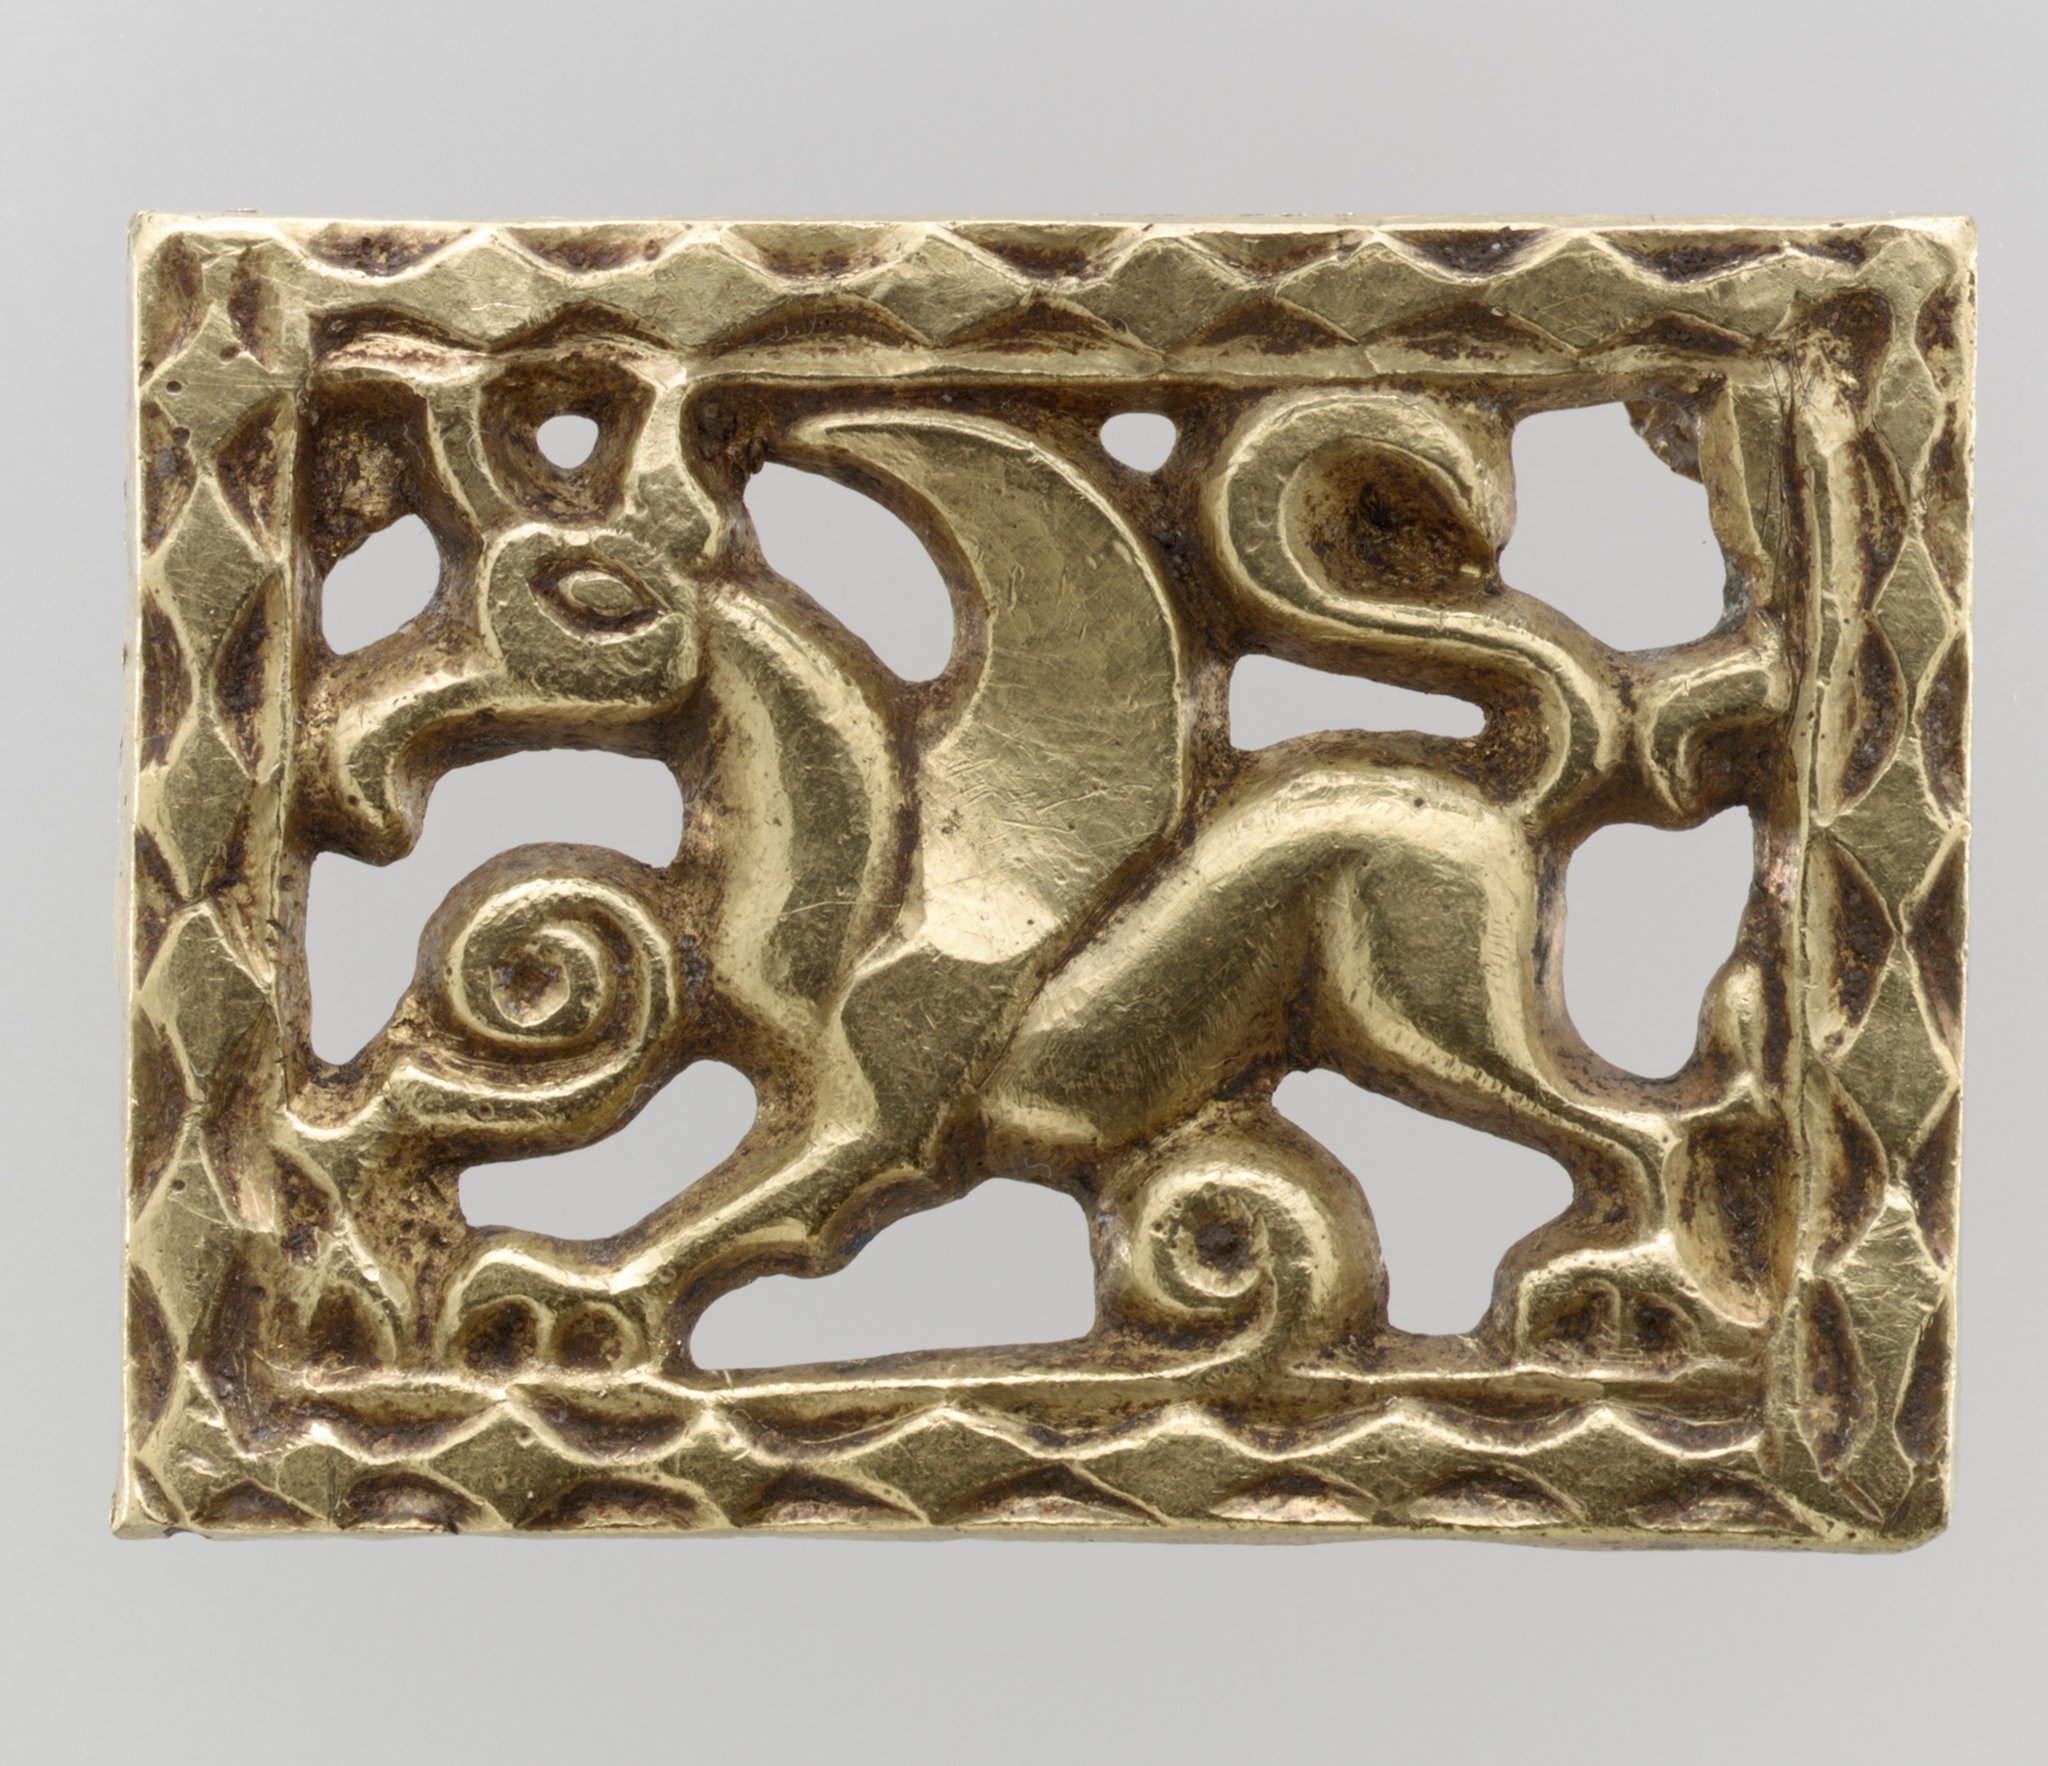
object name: belt mount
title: Gold Openwork Belt Mount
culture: avar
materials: gold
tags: griffins